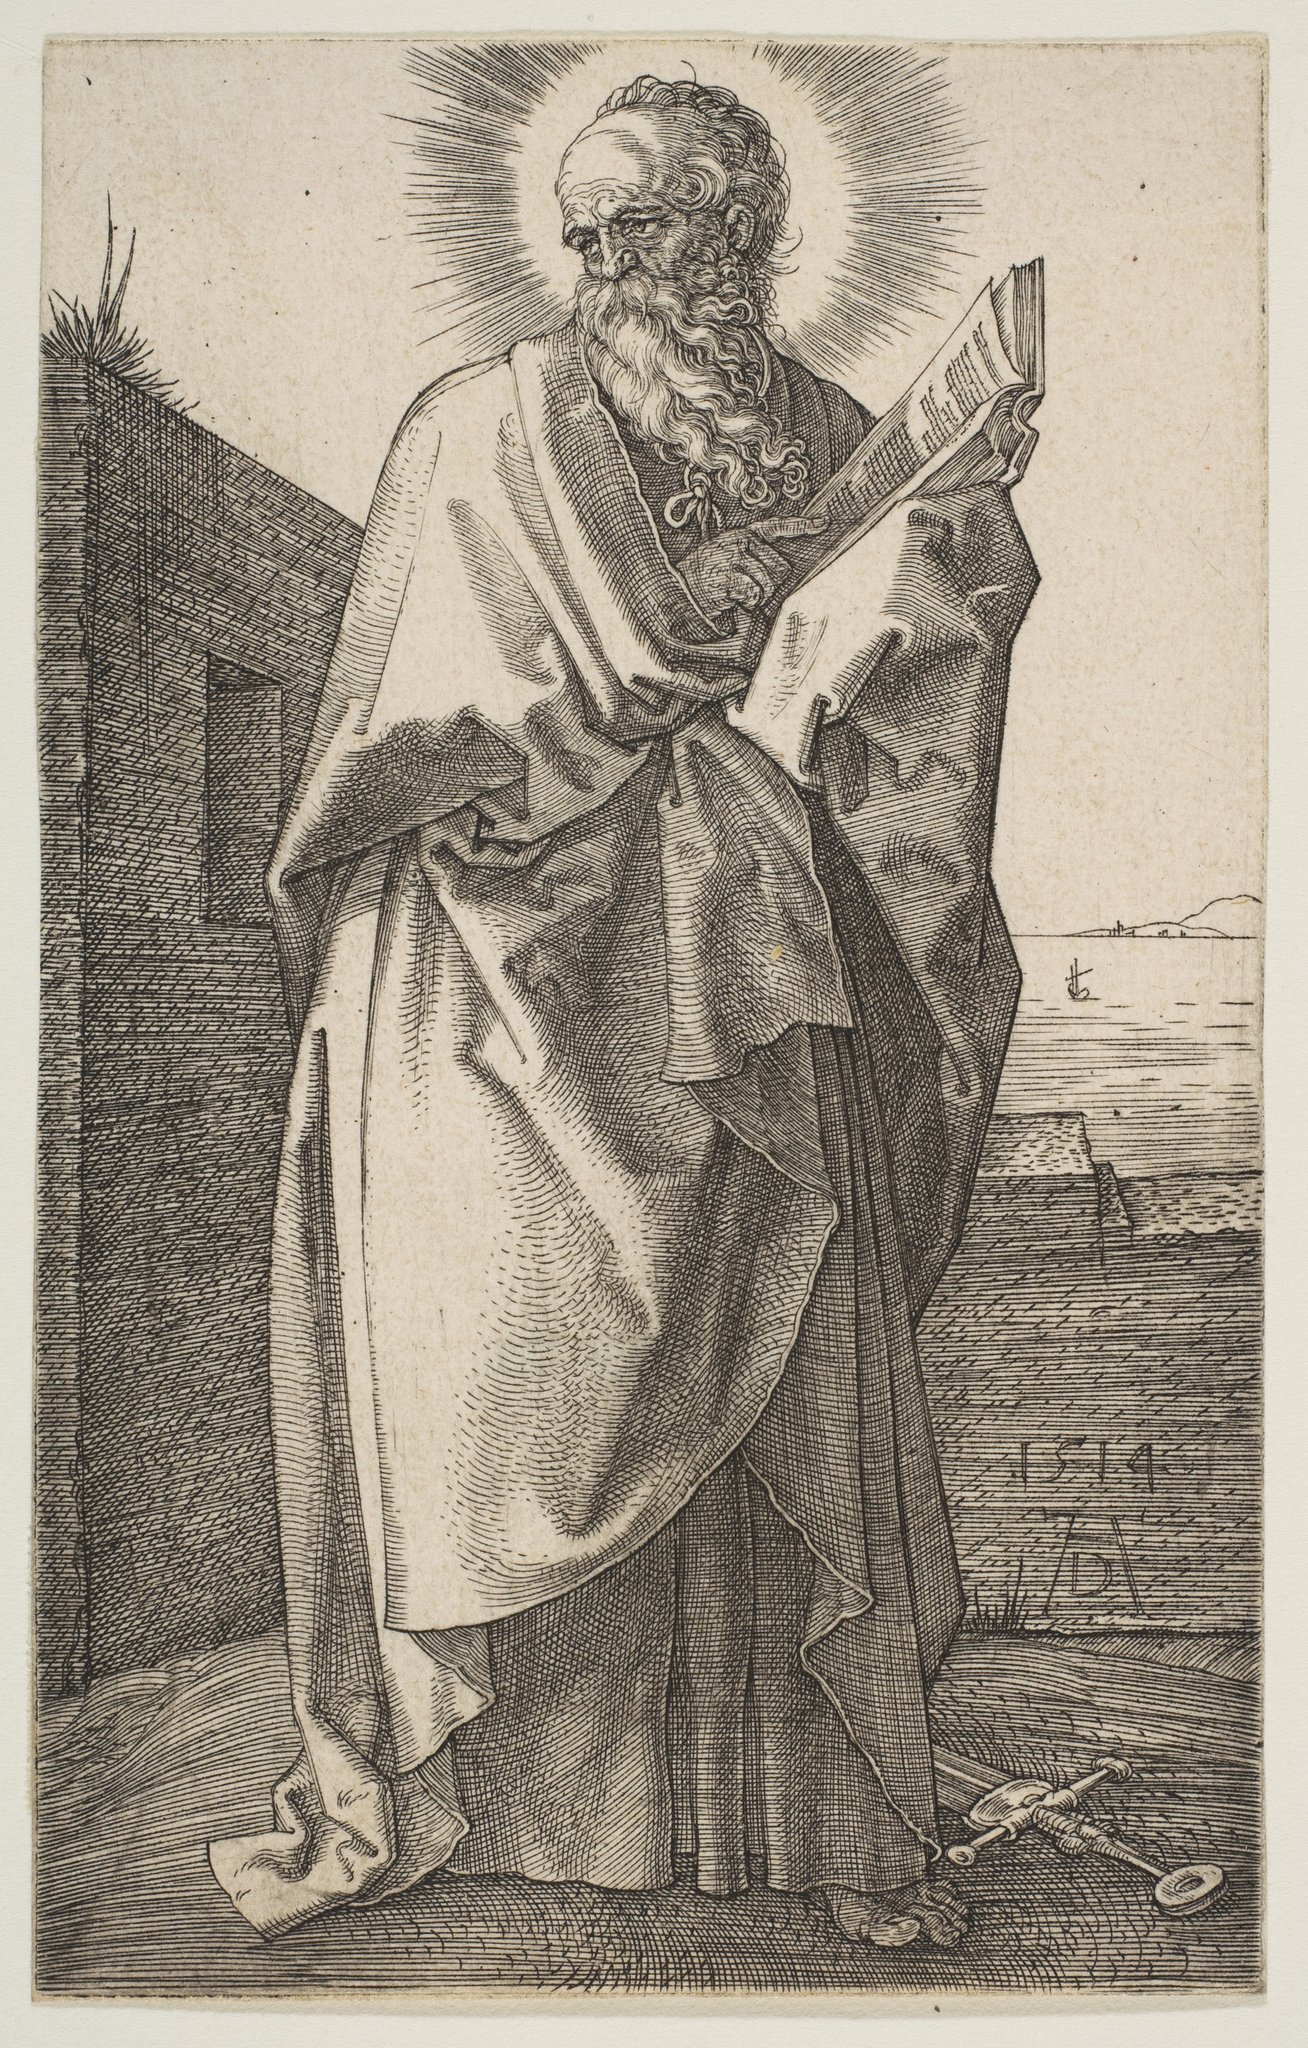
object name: print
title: Saint Paul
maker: albrecht dürer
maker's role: artist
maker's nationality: german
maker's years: 1471-1528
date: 1514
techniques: engraving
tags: saint paul